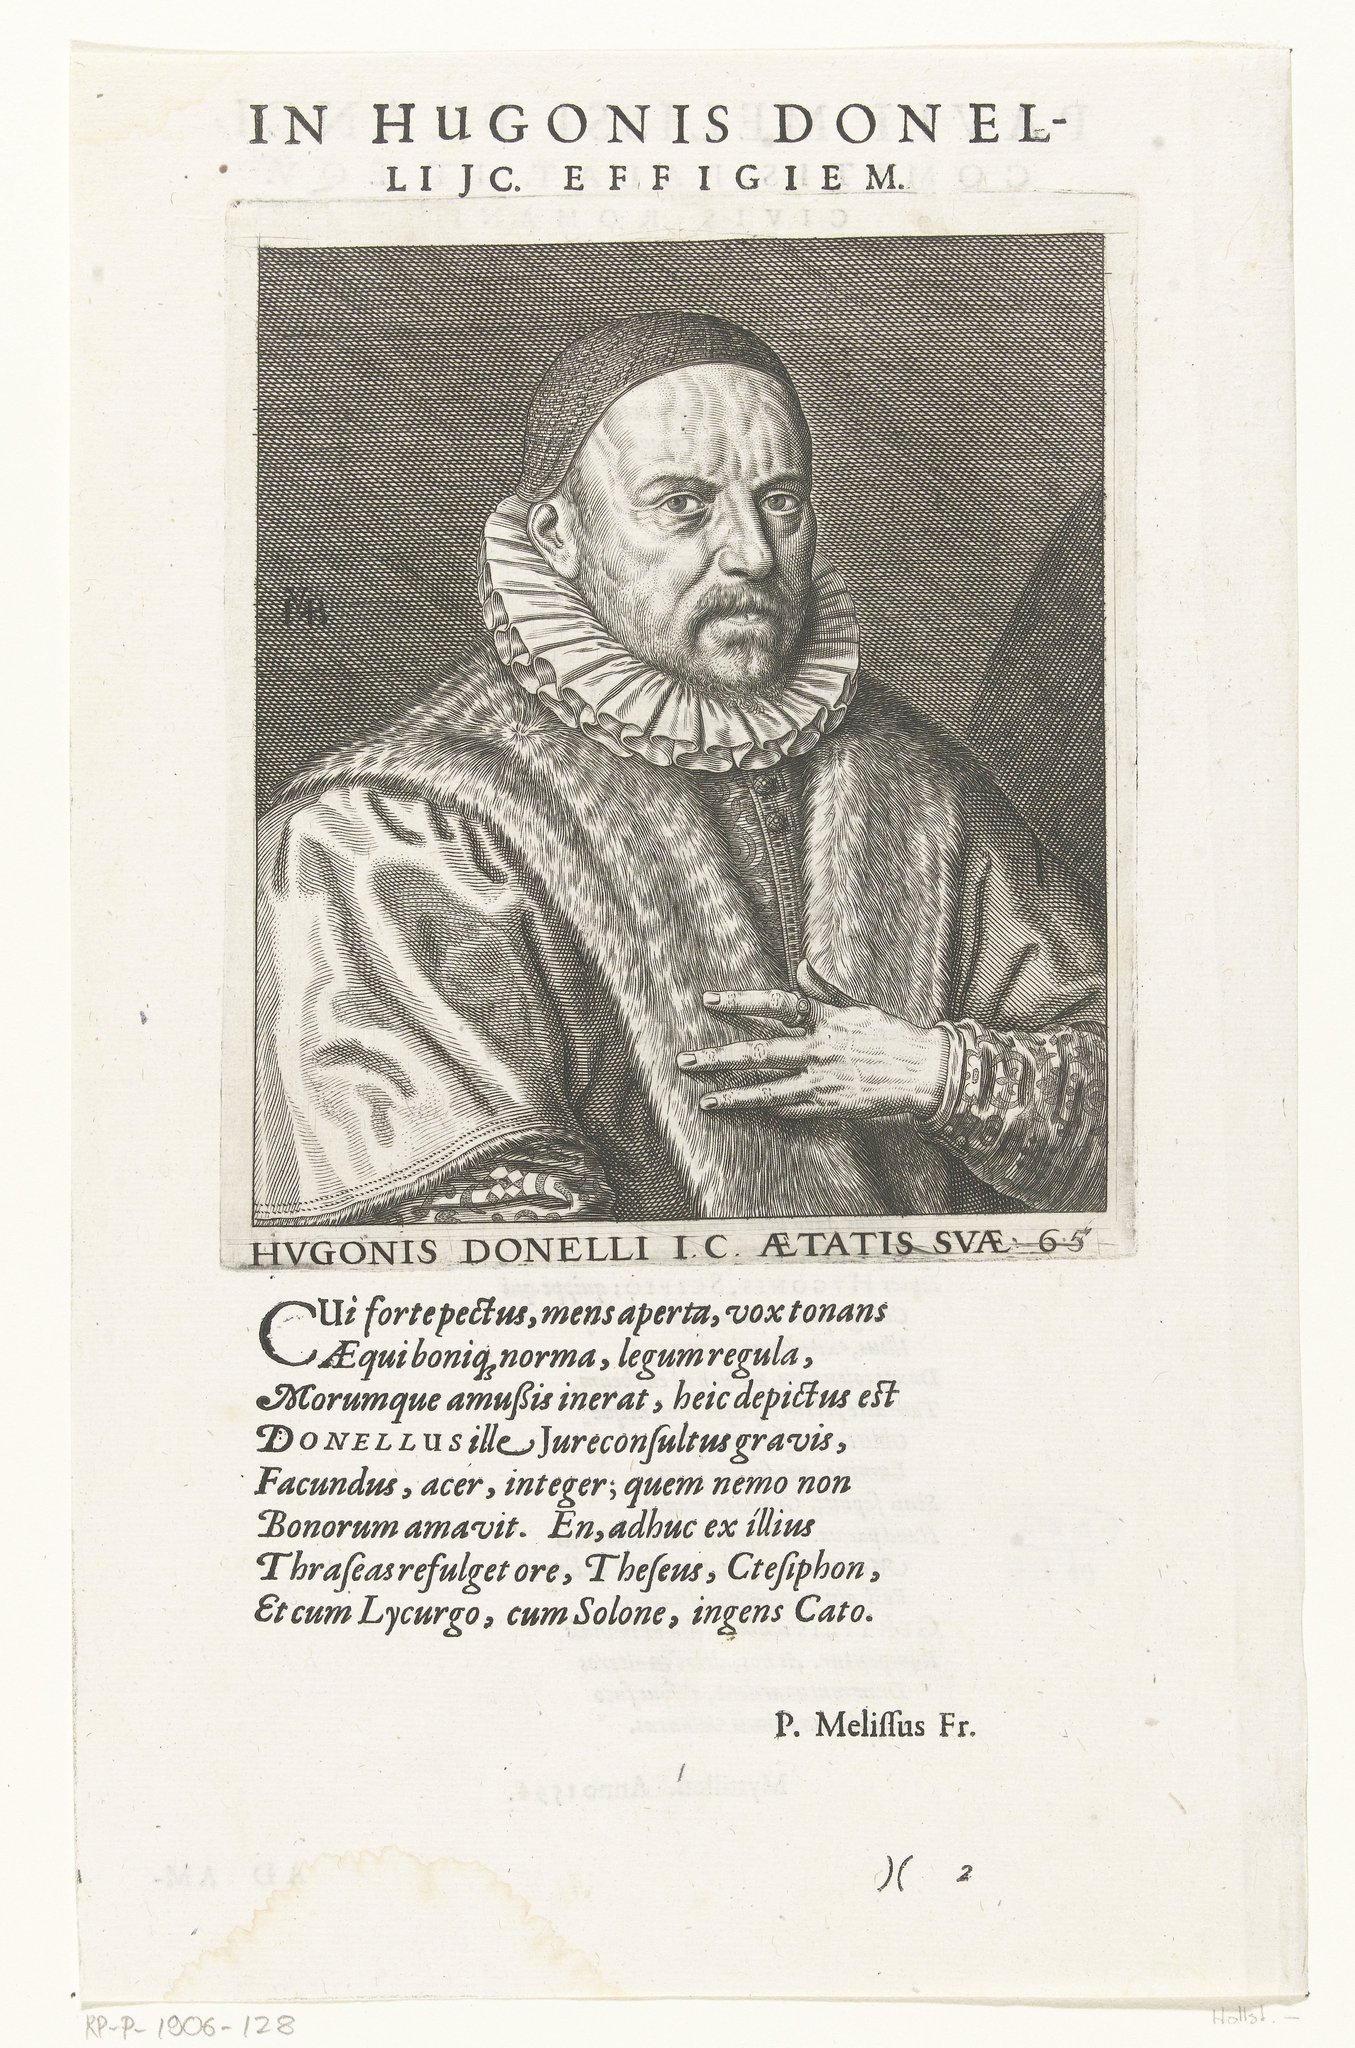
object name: print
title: Portret van Hugo Donellus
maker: theodor de bry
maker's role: draughtsman, print maker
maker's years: 1528-1598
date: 1596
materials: paper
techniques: engraving, letterpress printing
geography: frankfurt am main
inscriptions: collector's mark: Lugt 2228